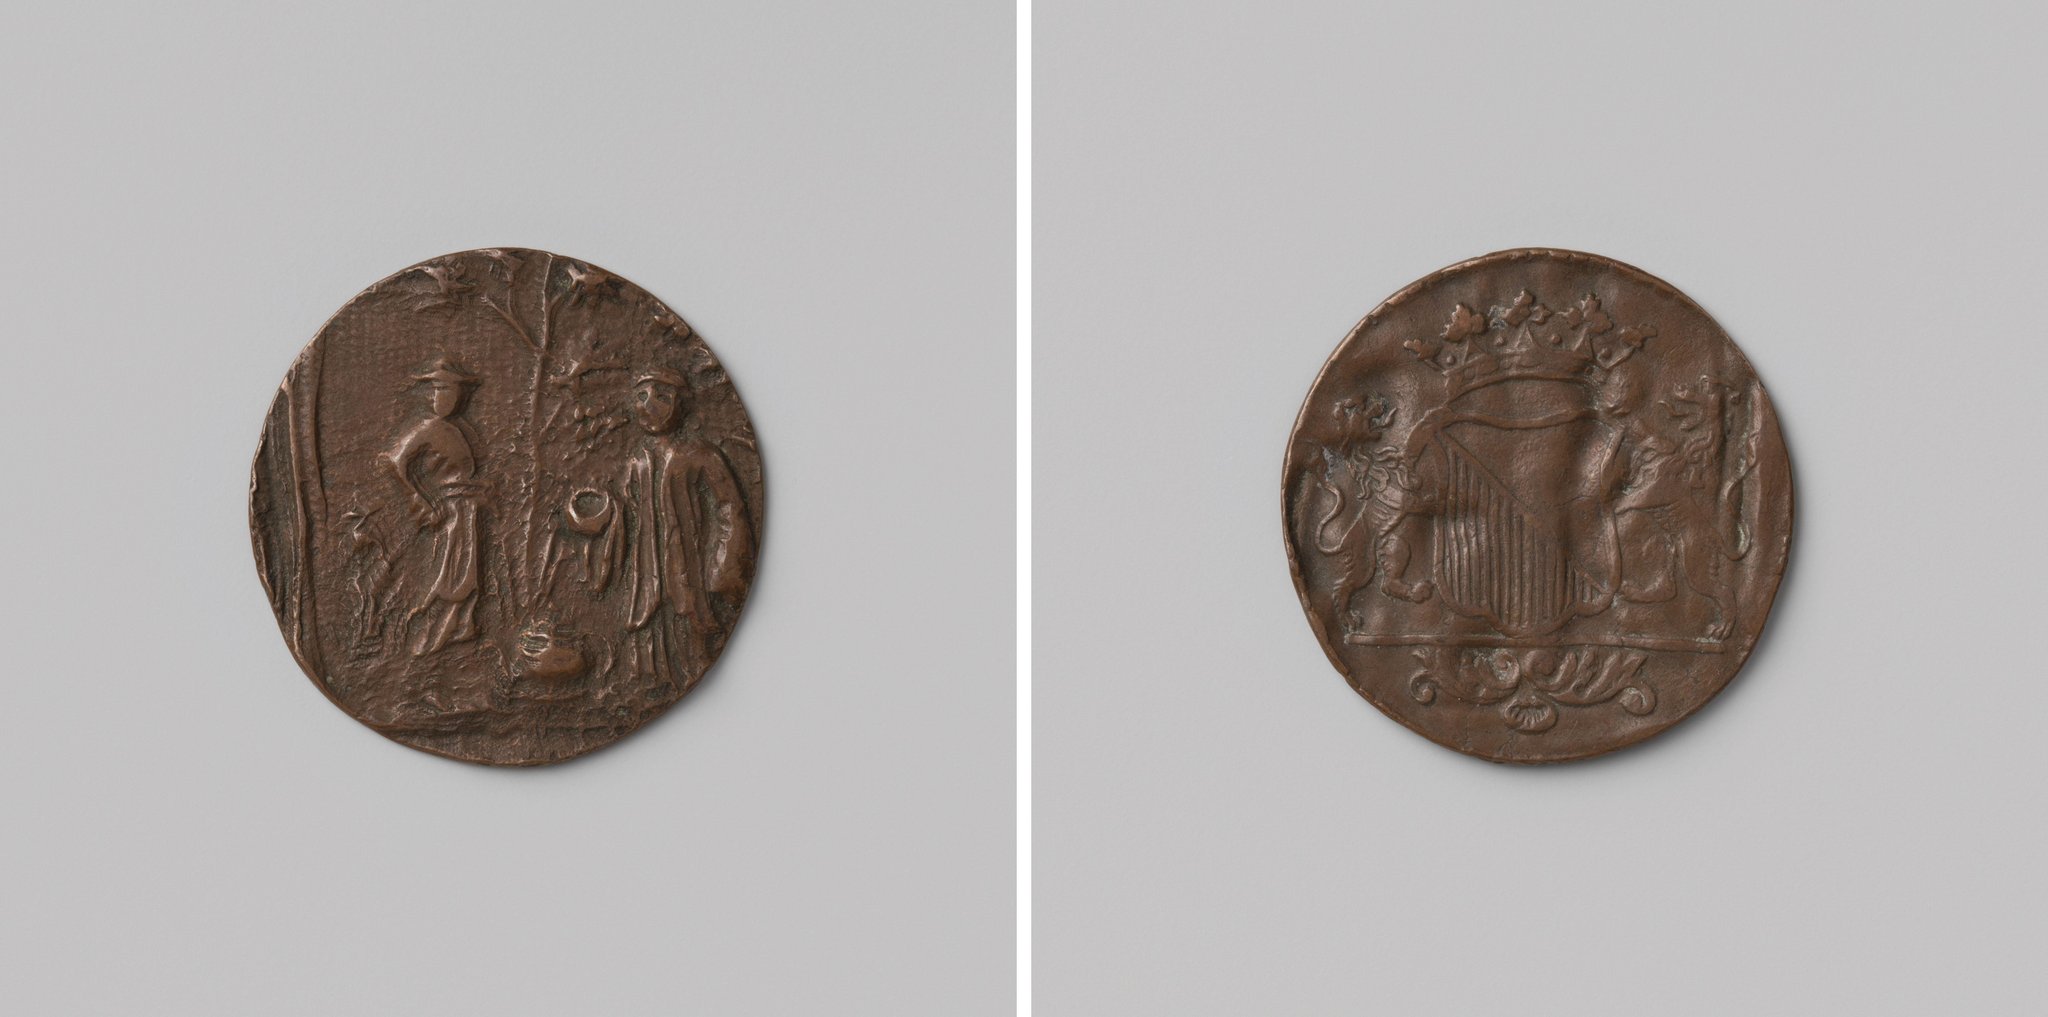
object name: medal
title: Penning met Chinese voorstelling, vervaardigd uit een duit van de stad Utrecht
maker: Anonymous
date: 1739-1794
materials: copper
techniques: striking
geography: utrecht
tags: utrecht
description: Koperen penning. Voorzijde: twee mannen in Chinese kledij, staande in tuin, waarbij rechter een kleine schotel in hand houdt. Keerzijde: gekroond wapenschild, geflankeerd door twee leeuwen; afsnede: ornament